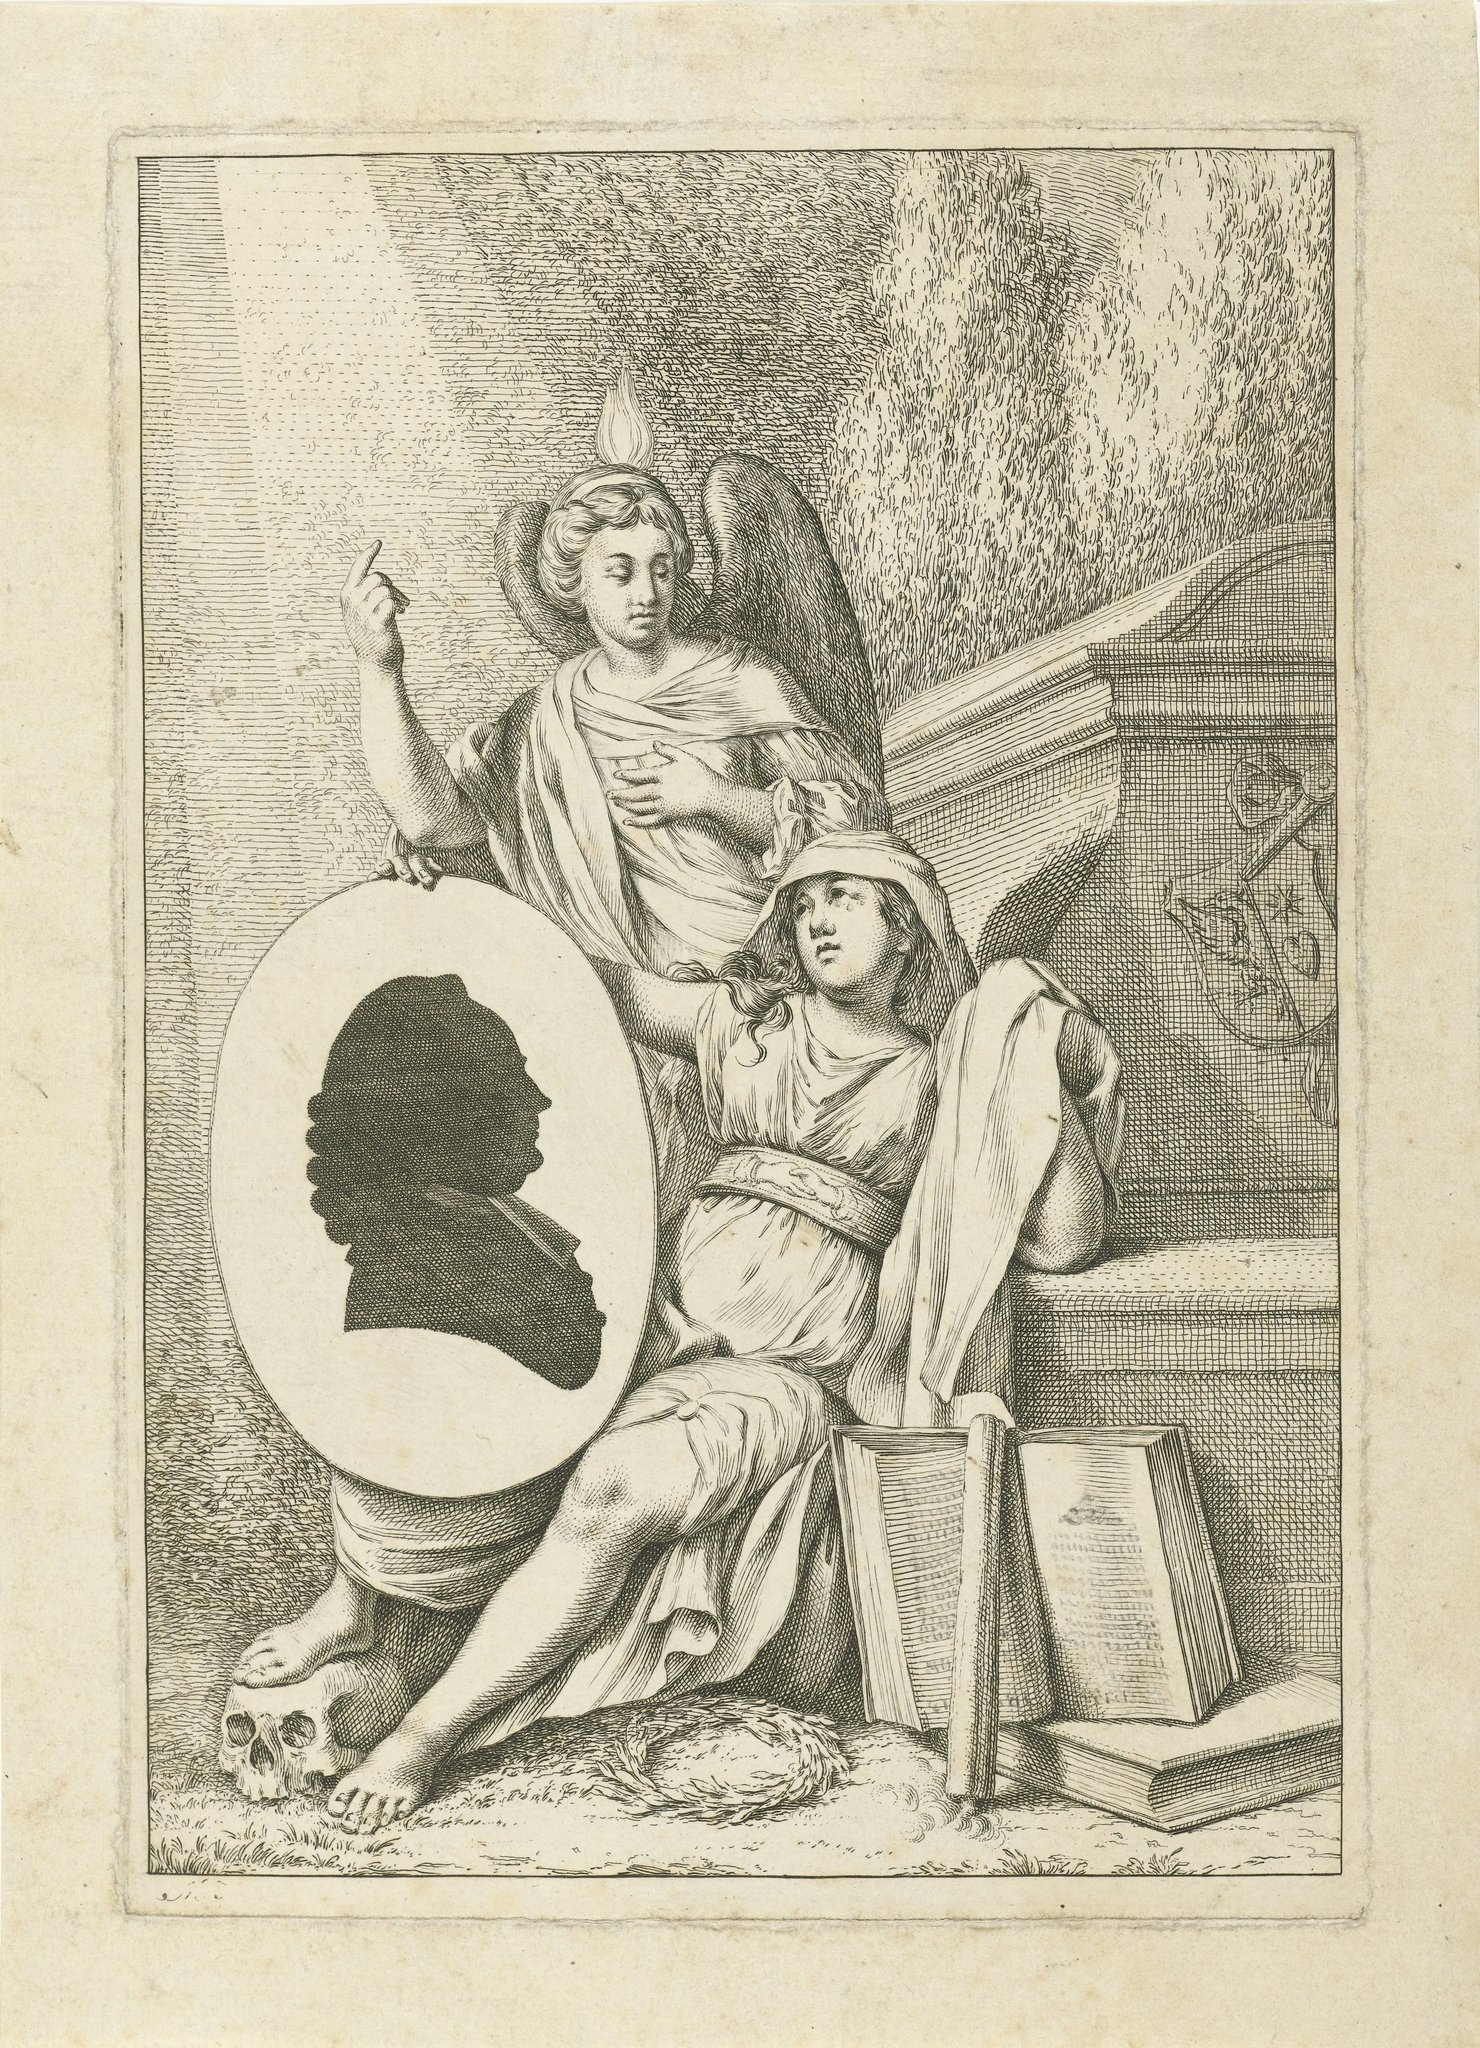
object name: print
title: Gedenkteken voor Johan Diederich Deiman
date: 1783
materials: paper, pencil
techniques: engraving, etching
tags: other memorial structures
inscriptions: collector's mark: Lugt 2228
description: Twee allegorische figuren bij een grafmonument. De godsvrucht wordt gepersonifieerd door een engel met vlam op het hoofd, die wijst naar een lichtstraal. De vriendschap wordt verbeeld door een wenende vrouw met een schedel onder haar voet en een lauwerkrans en enkele boeken op de grond naast haar. Zij toont het silhouetportret van J.D. Deiman.